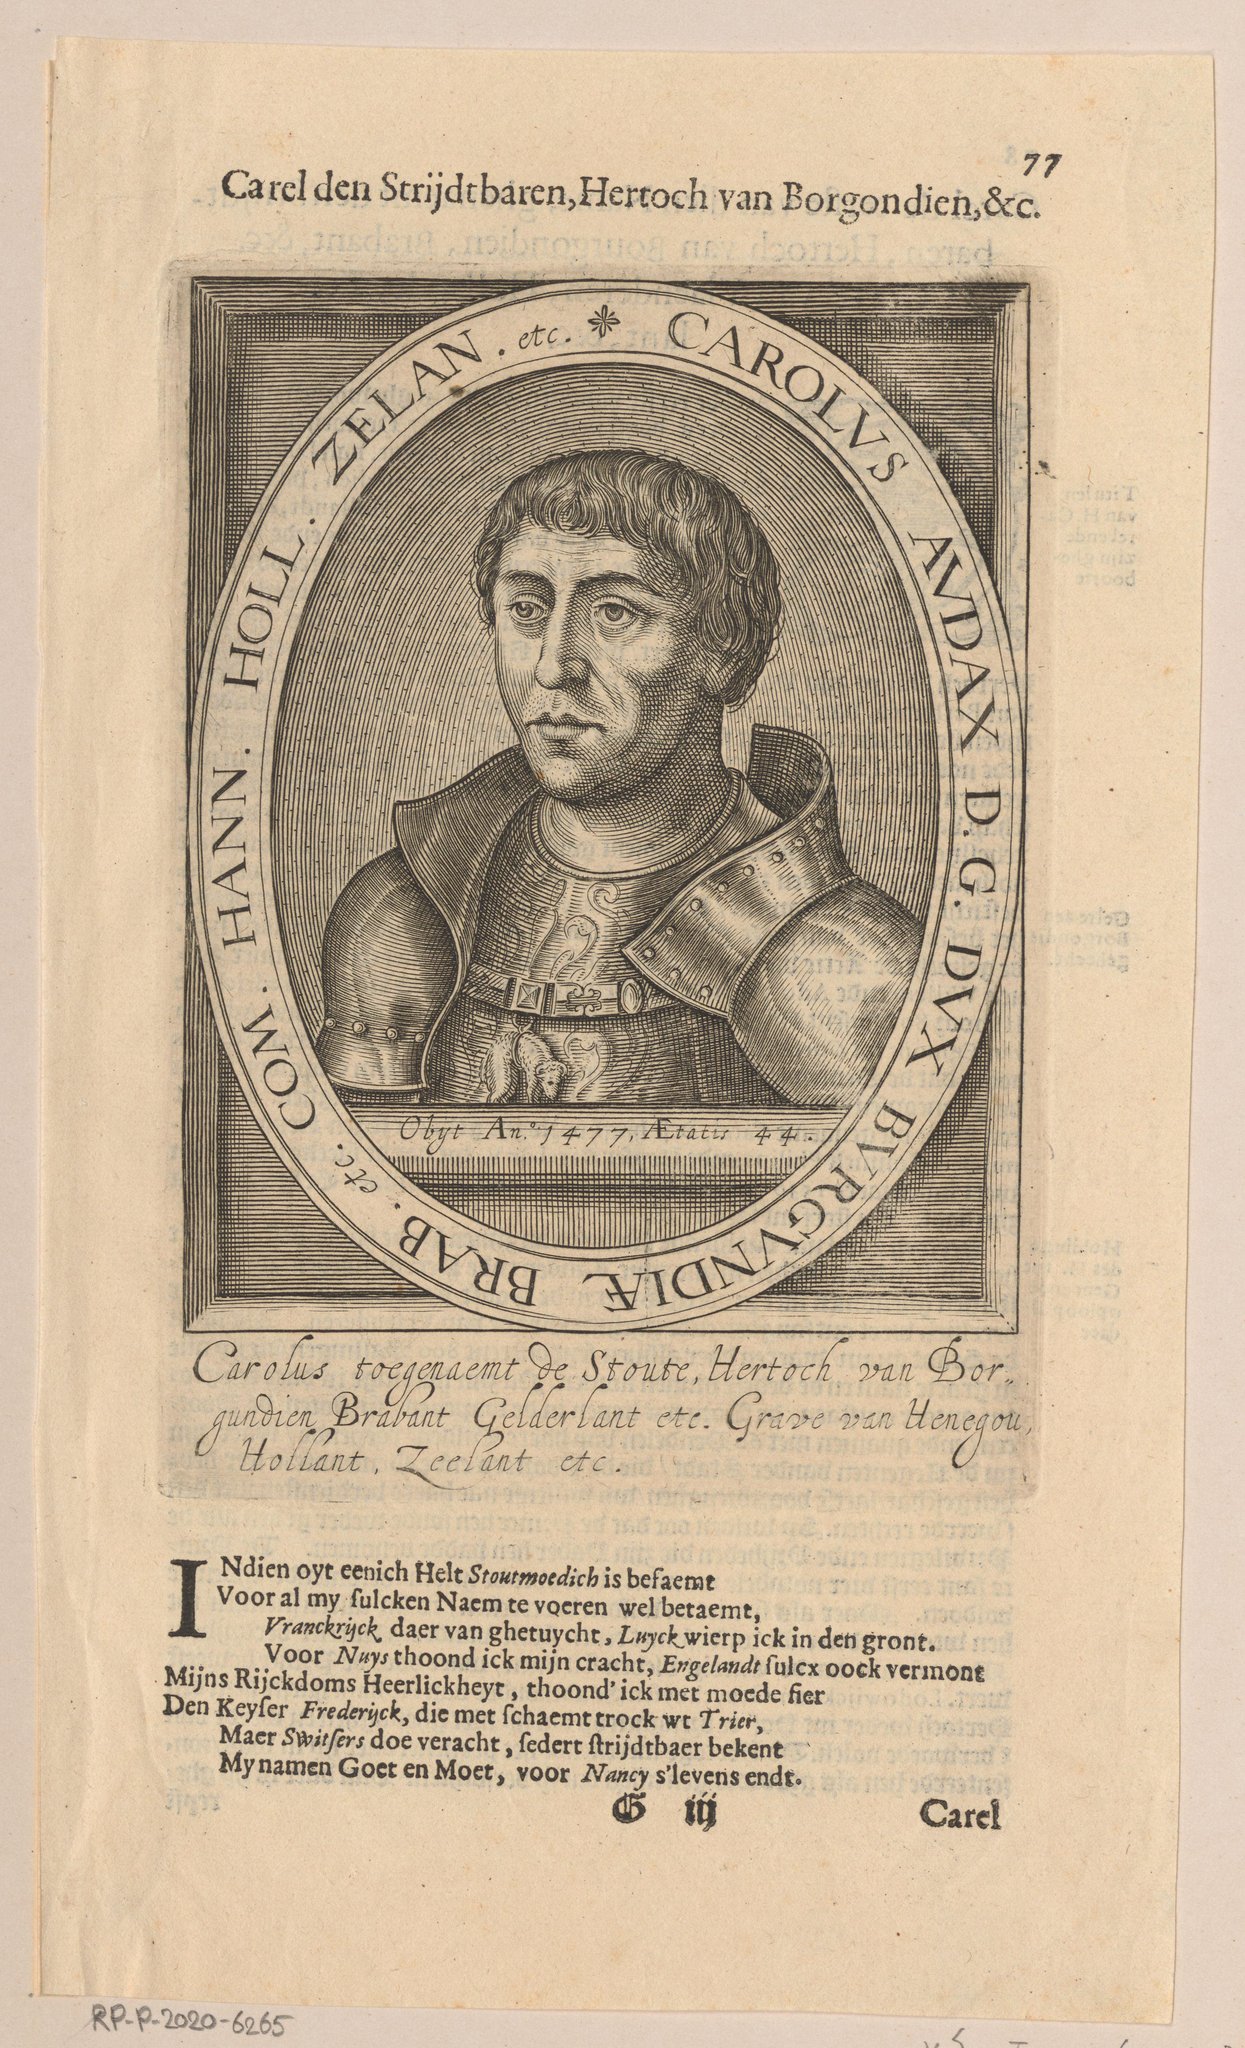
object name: print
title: Portret van Karel de Stoute, hertog van Bourgondië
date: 1617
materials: paper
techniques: engraving, letterpress printing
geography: delft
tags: earl, charles the bold (duke of burgundy), historical persons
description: Prent uit: Clerck, Nicolaes de. Tooneel der beroemder hertogen princen, graven ende krygs-helden (...). Delft: Nicolaes de Clerck, 1617, p. 77.